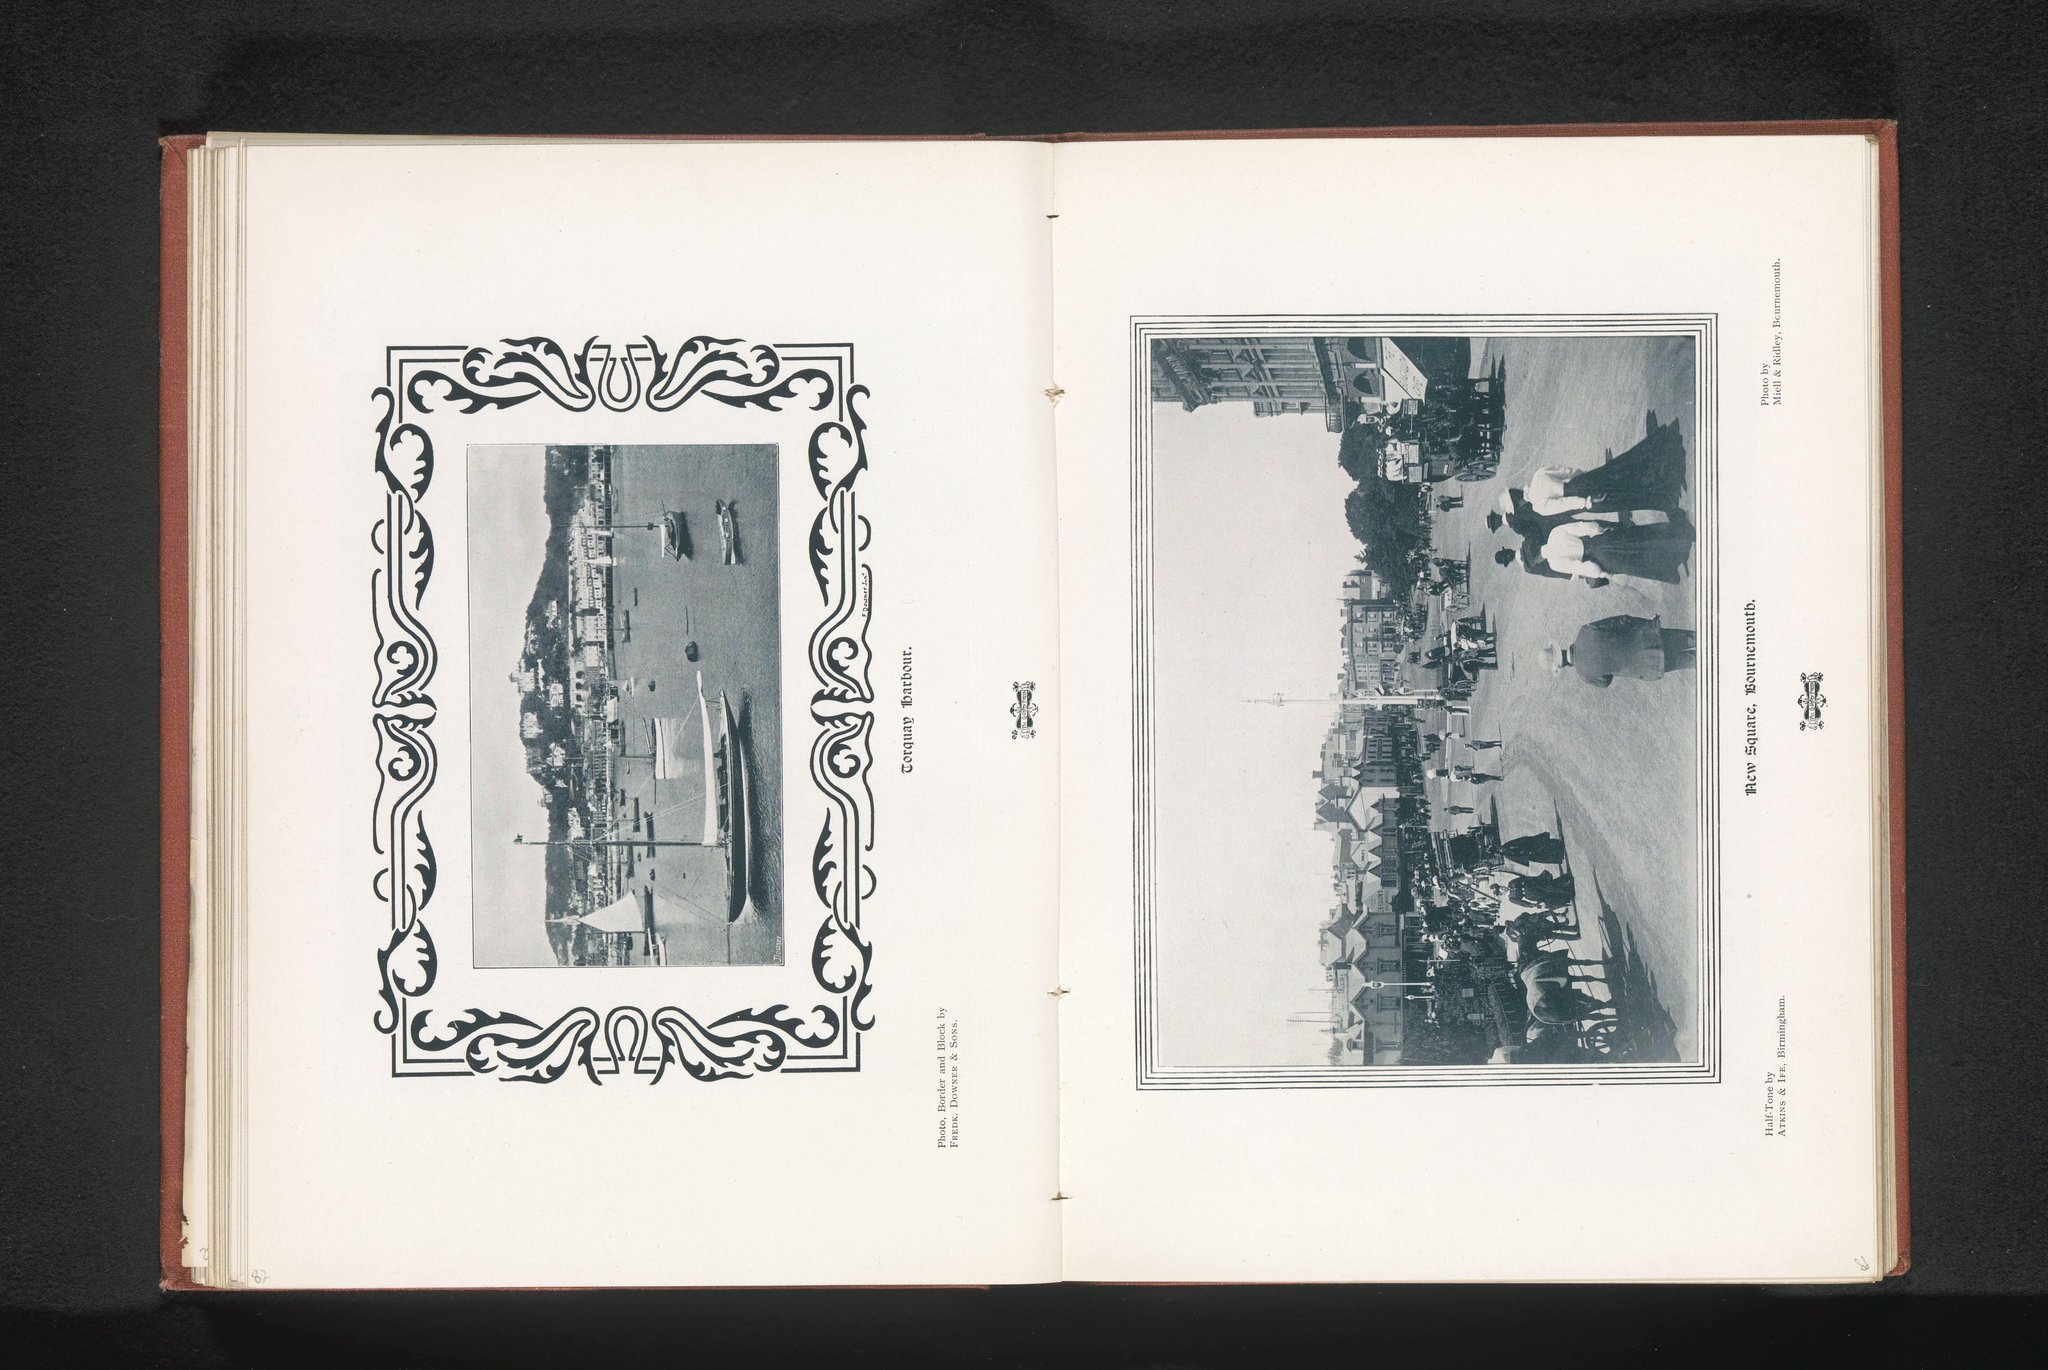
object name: photomechanical print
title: New square, Bournemouth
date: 1895-1900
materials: paper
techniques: autotype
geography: bournemouth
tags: square, place, circus, etc., street (+ city(-scape) with figures, staffage)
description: Prent op zevende ongenummerde pagina na pagina 68.